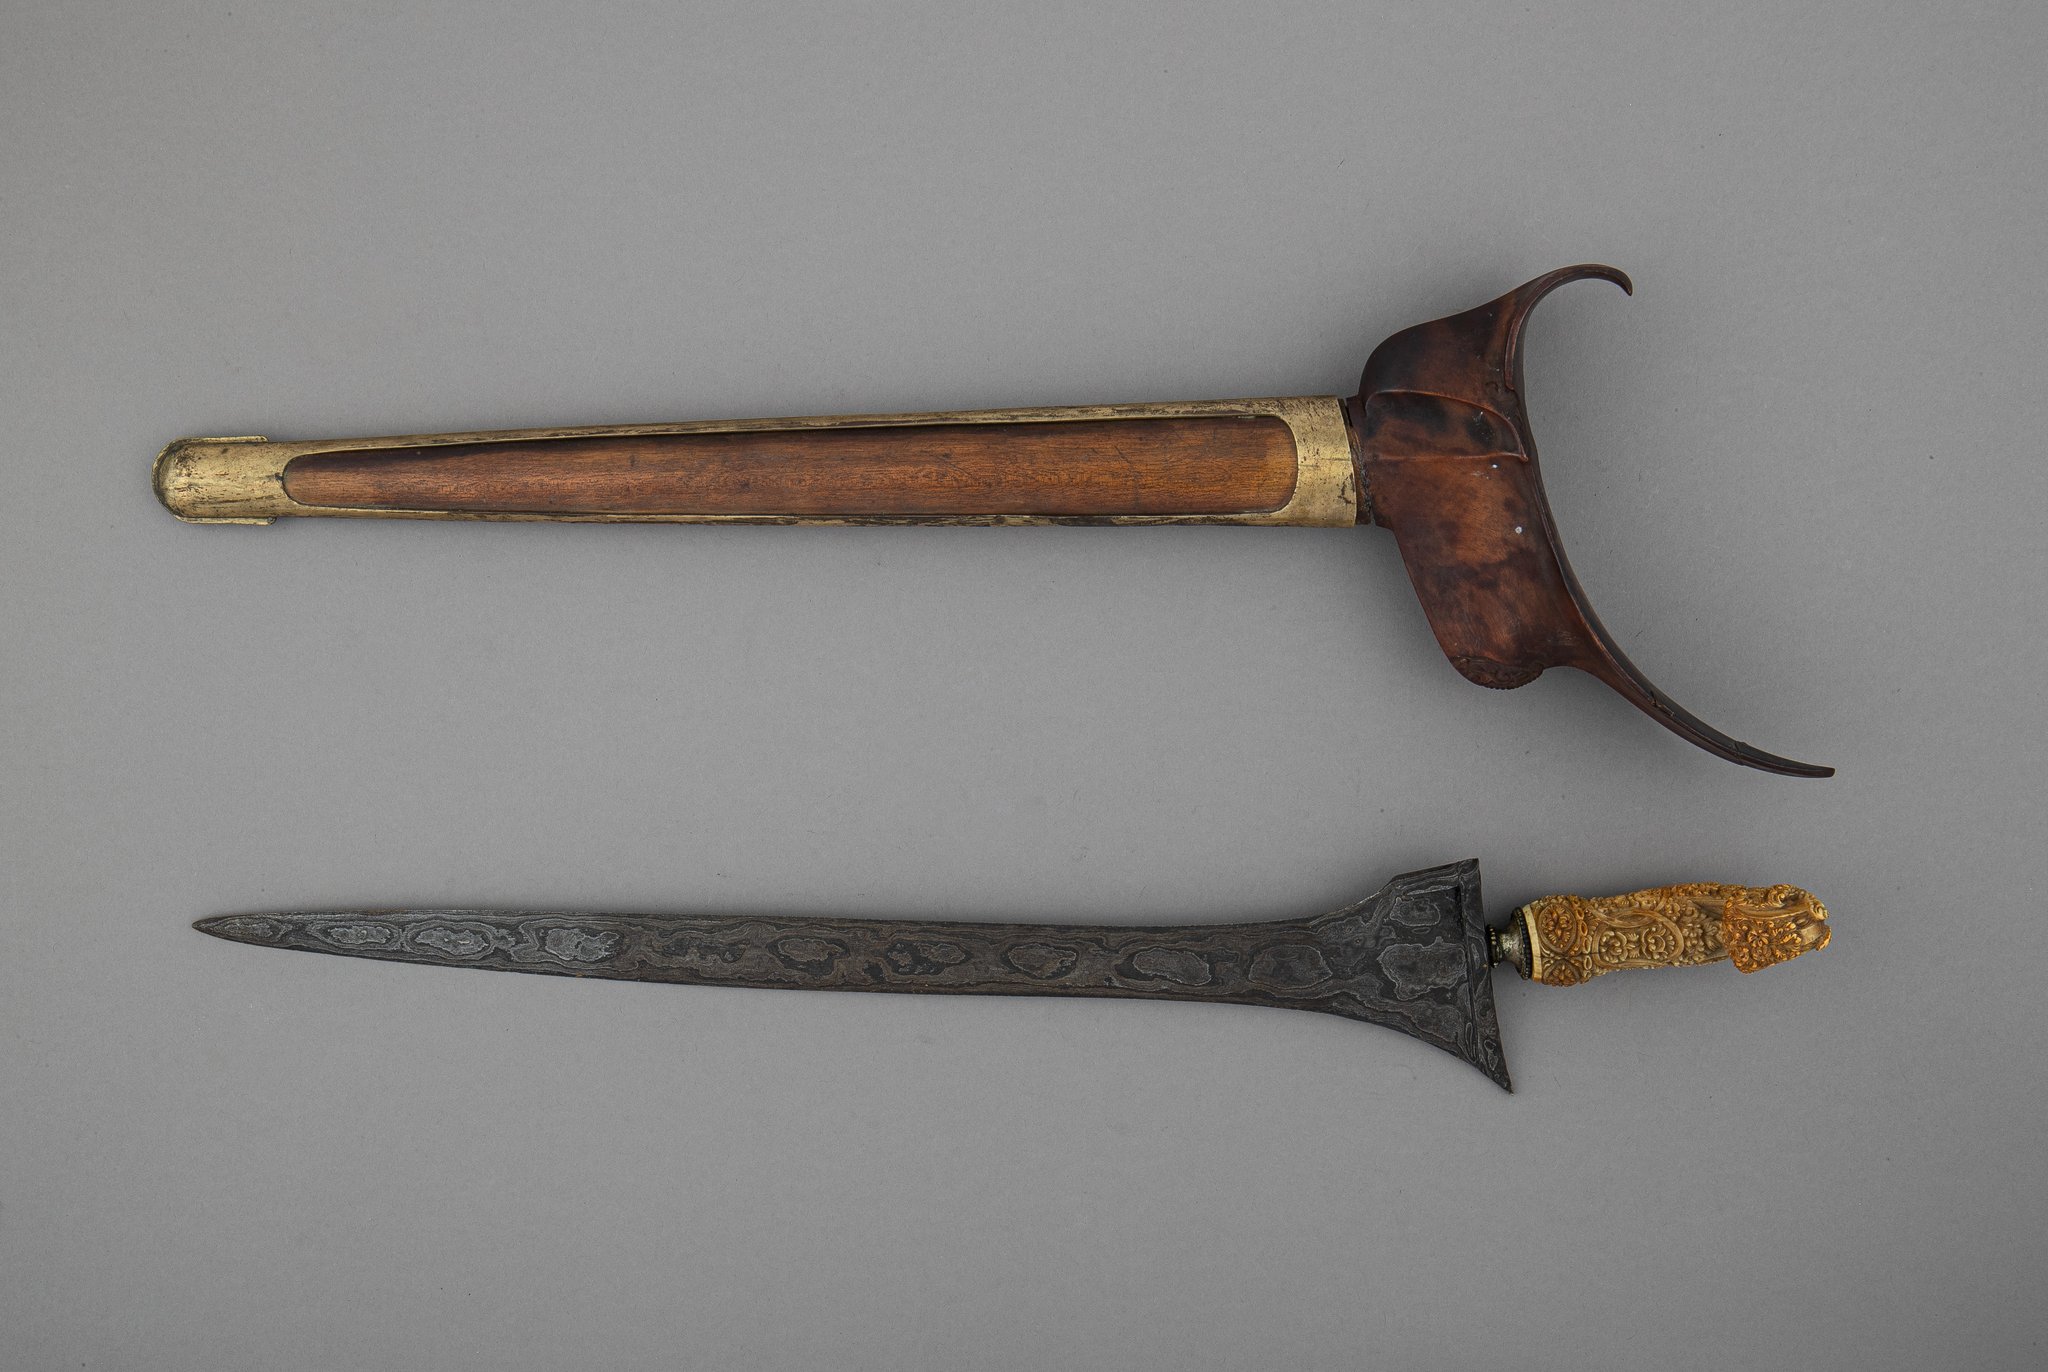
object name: kris with sheath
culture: madurese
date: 1501-1900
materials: brass, ivory, steel, wood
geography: indonesia